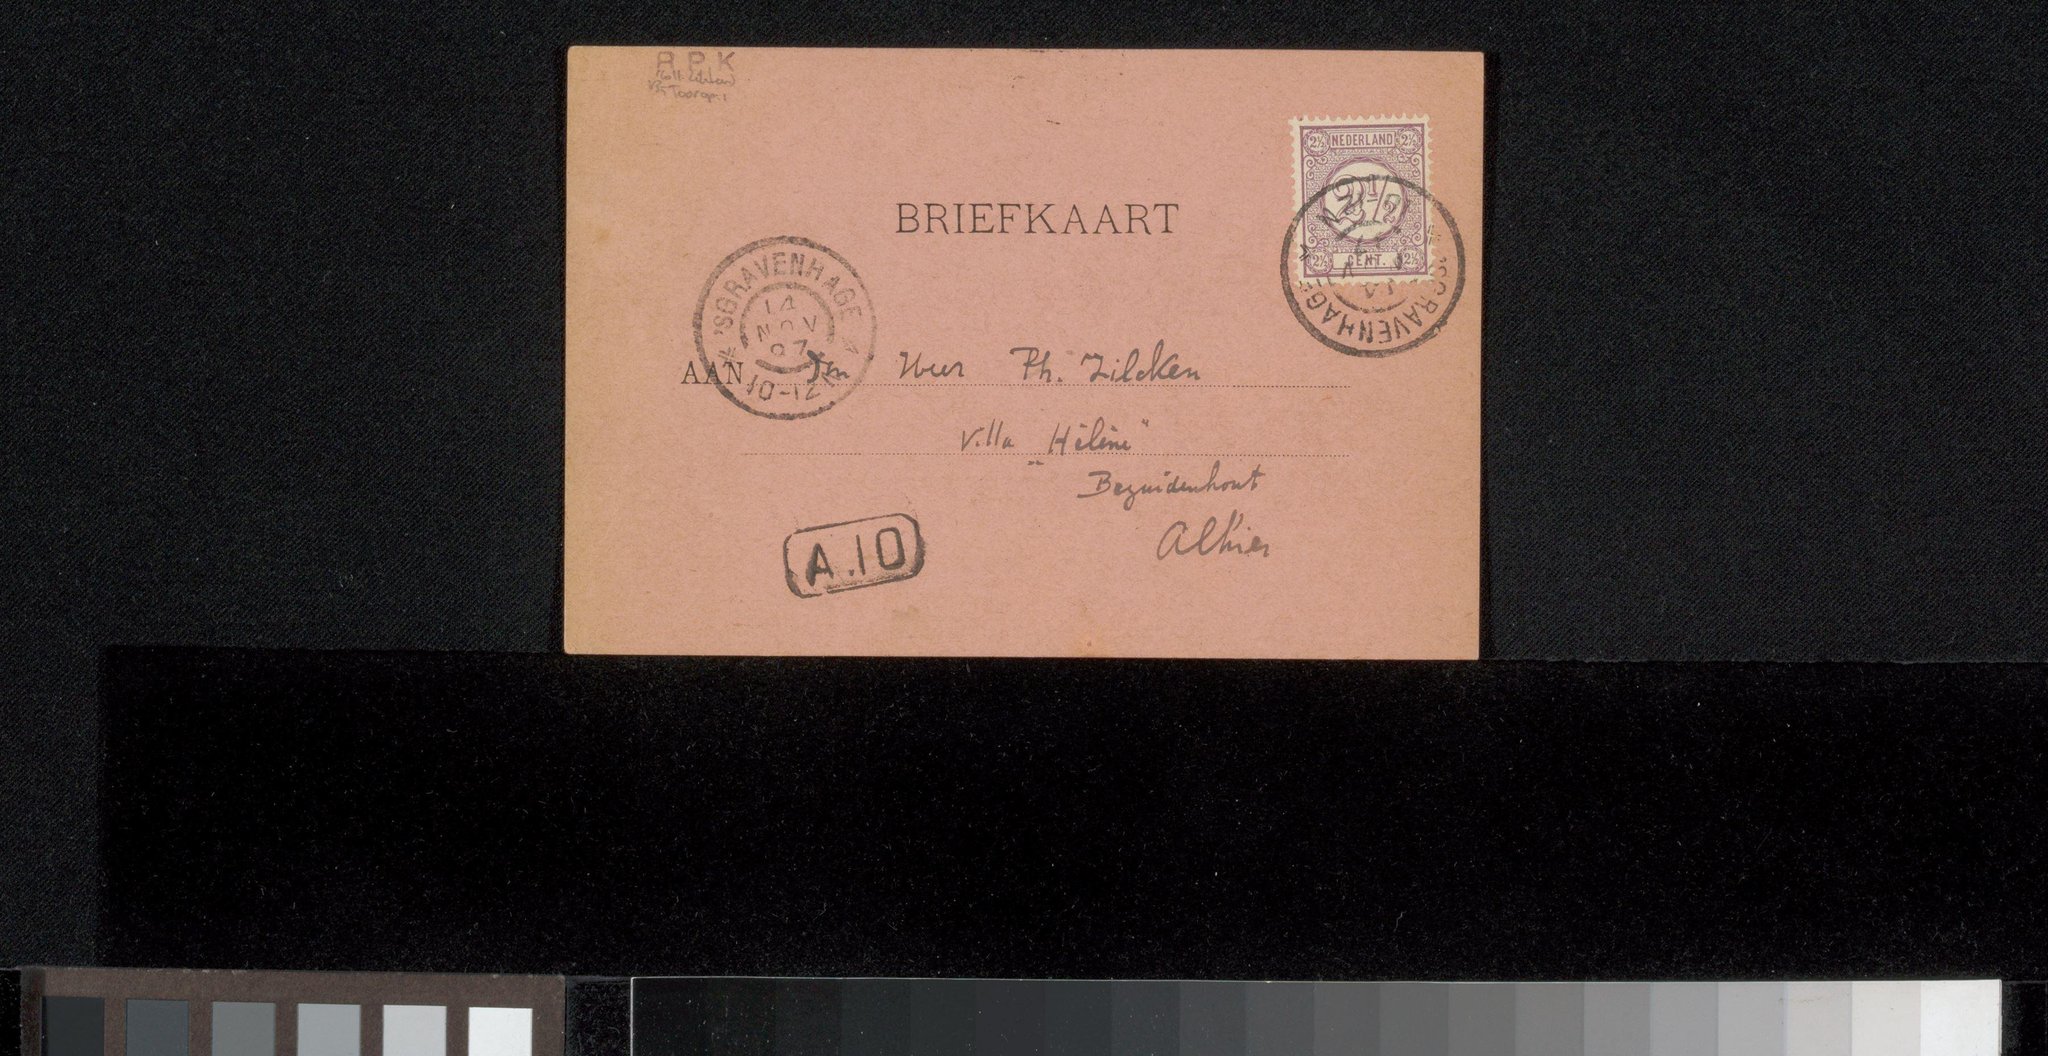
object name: postcard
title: Briefkaart aan Philip Zilcken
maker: jan toorop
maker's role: draughtsman, painter, print maker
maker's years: 1858-1928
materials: cardboard, ink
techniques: pen, writing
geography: the hague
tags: painter, draughtsman, philip zilcken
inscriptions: collector's mark: ‘RPK’